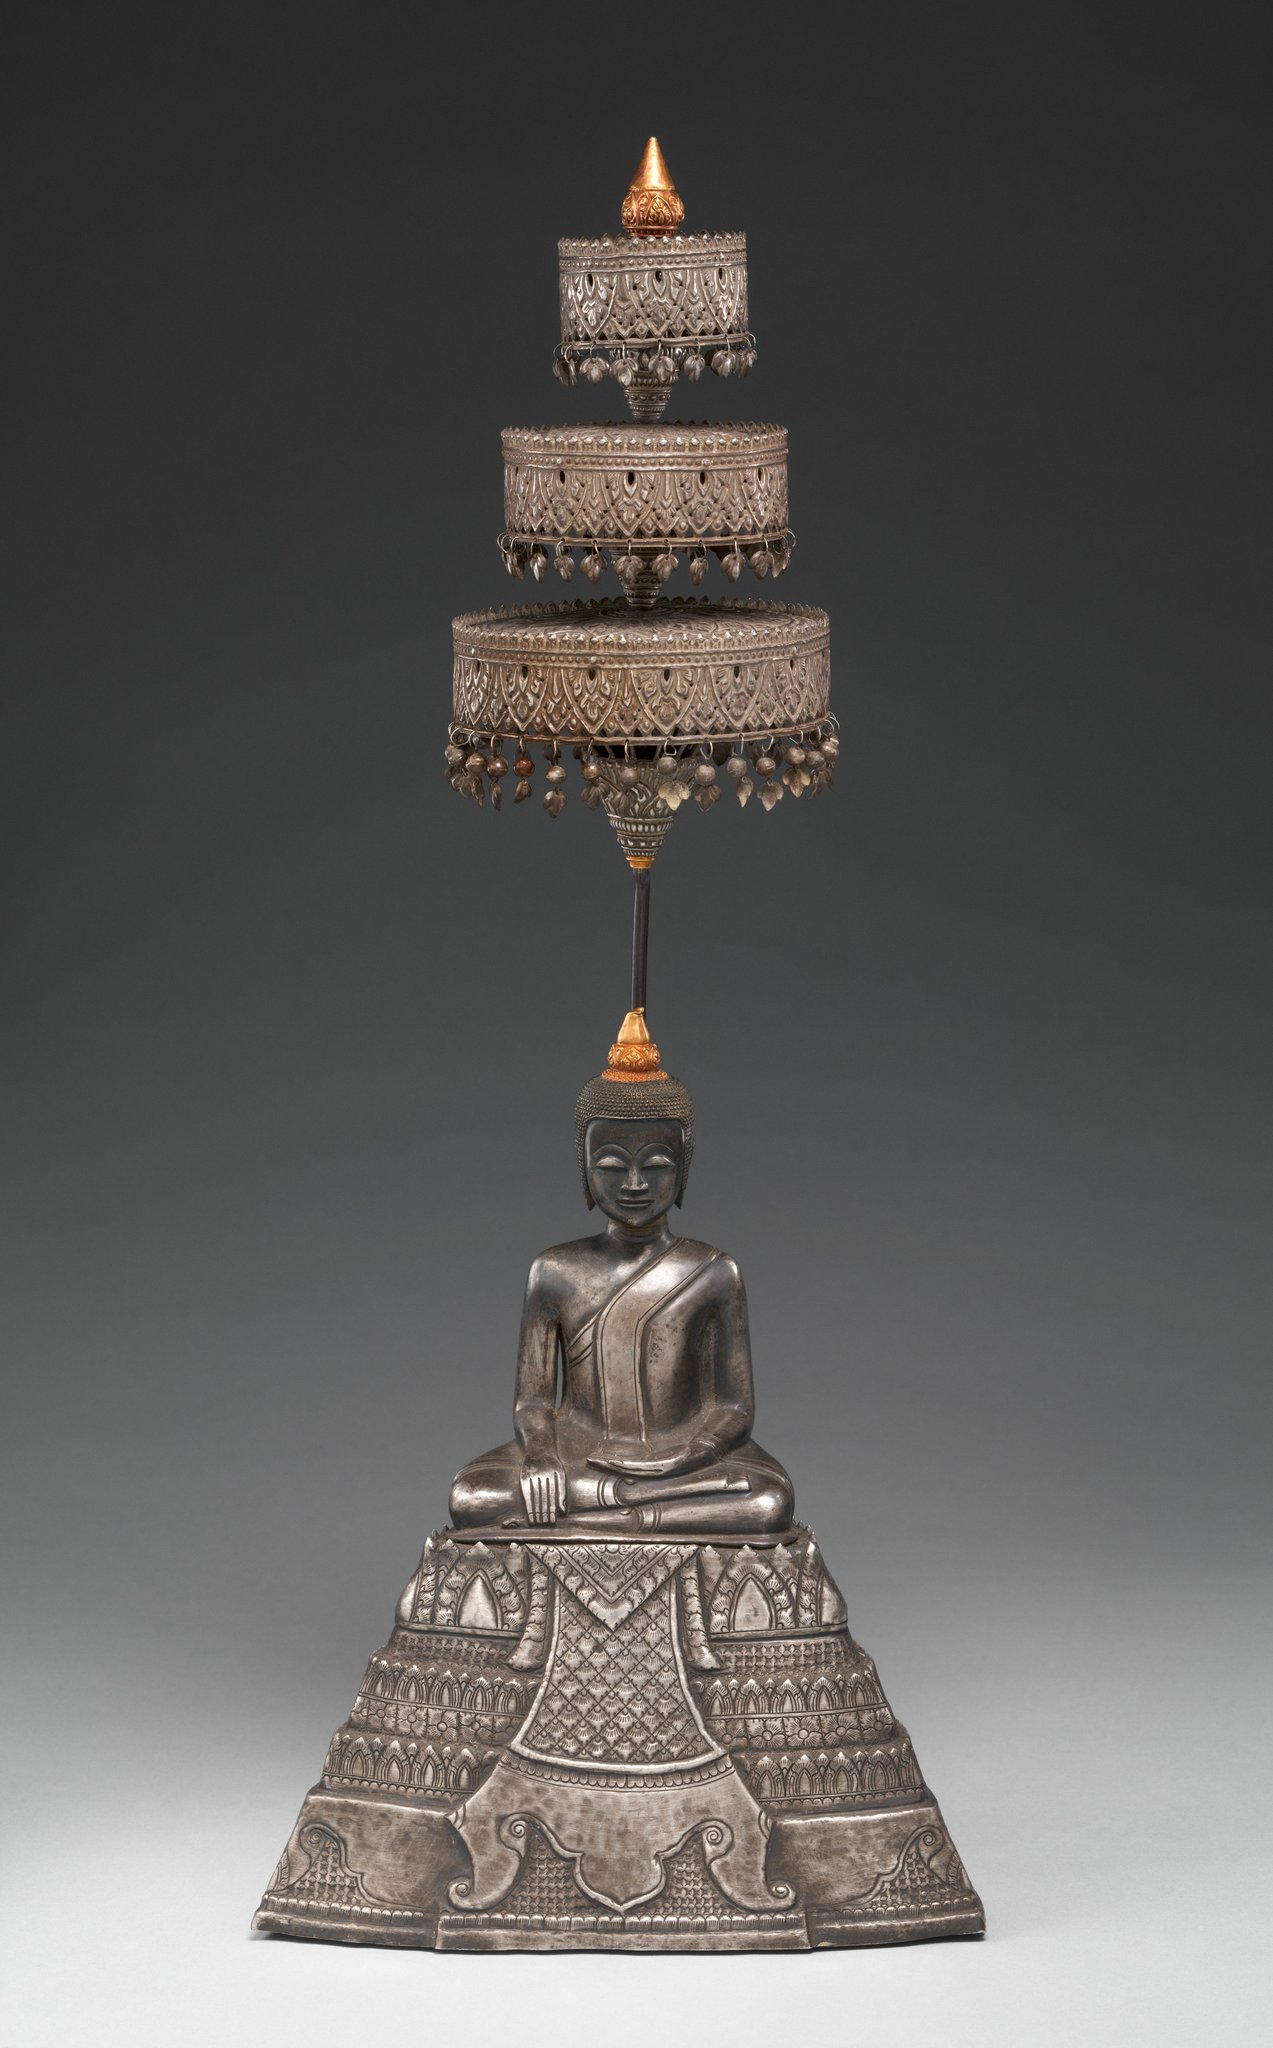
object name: figure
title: Enthroned Buddha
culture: cambodian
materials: clay, gold, silver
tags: buddhism,buddha